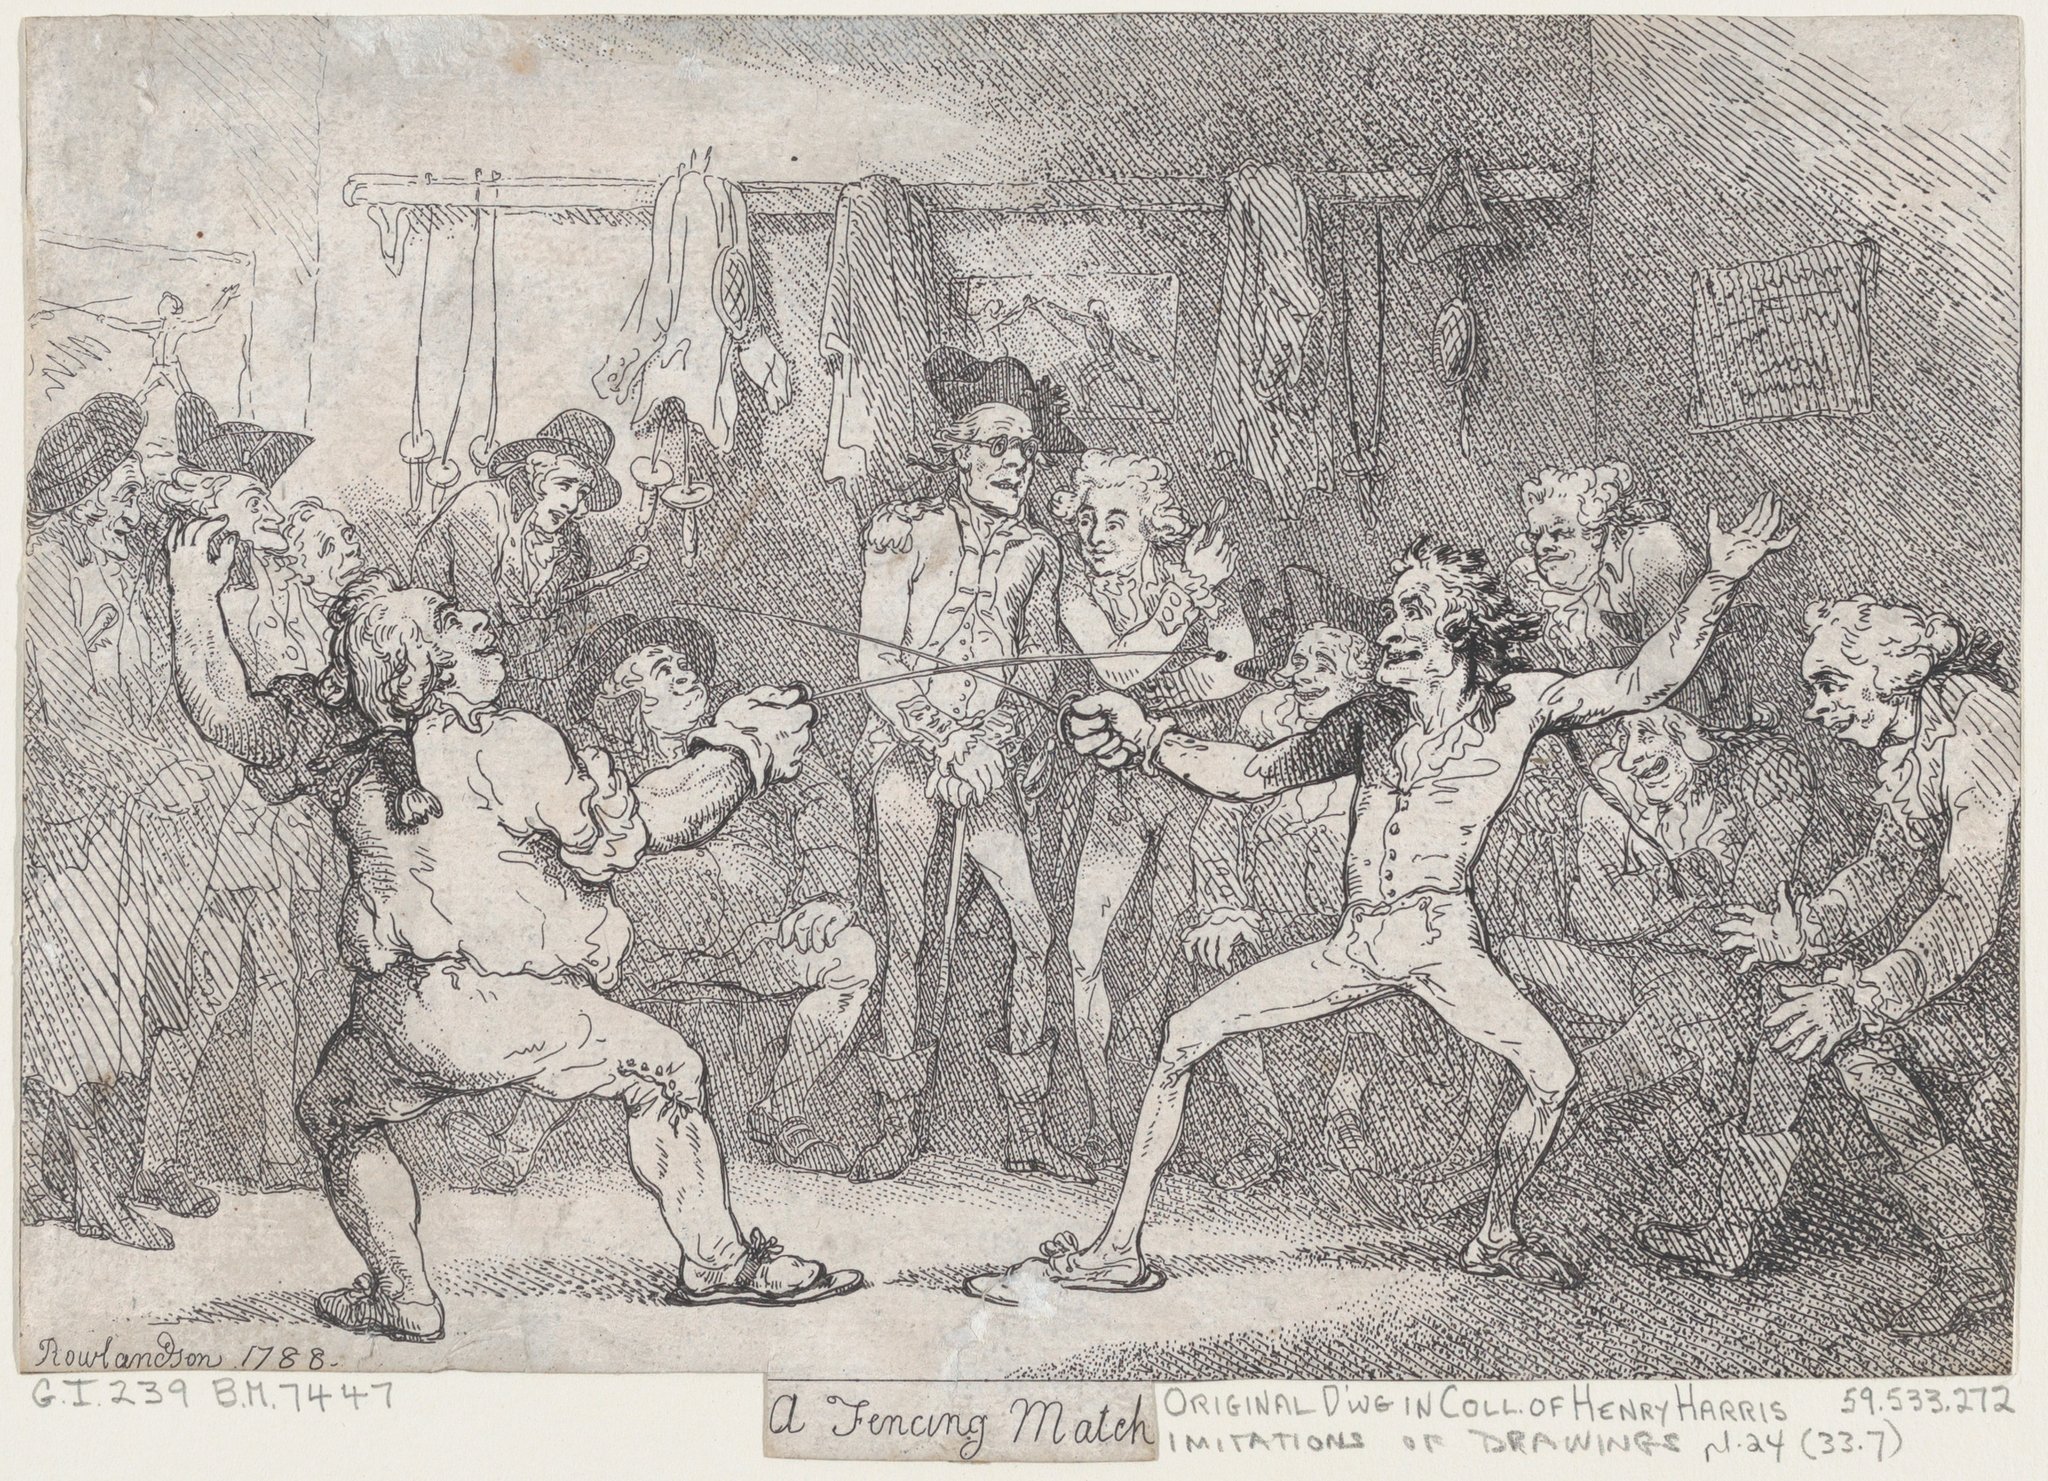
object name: print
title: A Fencing Match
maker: thomas rowlandson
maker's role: artist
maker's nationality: british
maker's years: 1757-1827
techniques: etching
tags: satire,men,spectators